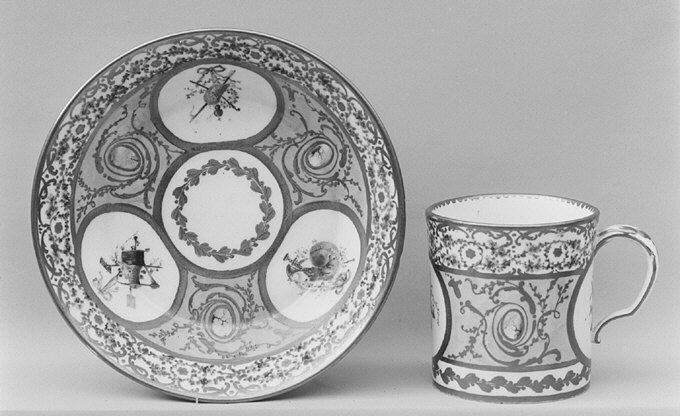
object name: saucer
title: Saucer (soucoupe)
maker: sèvres manufactory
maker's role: manufactory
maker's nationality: french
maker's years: 1740-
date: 1783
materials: soft paste porcelain